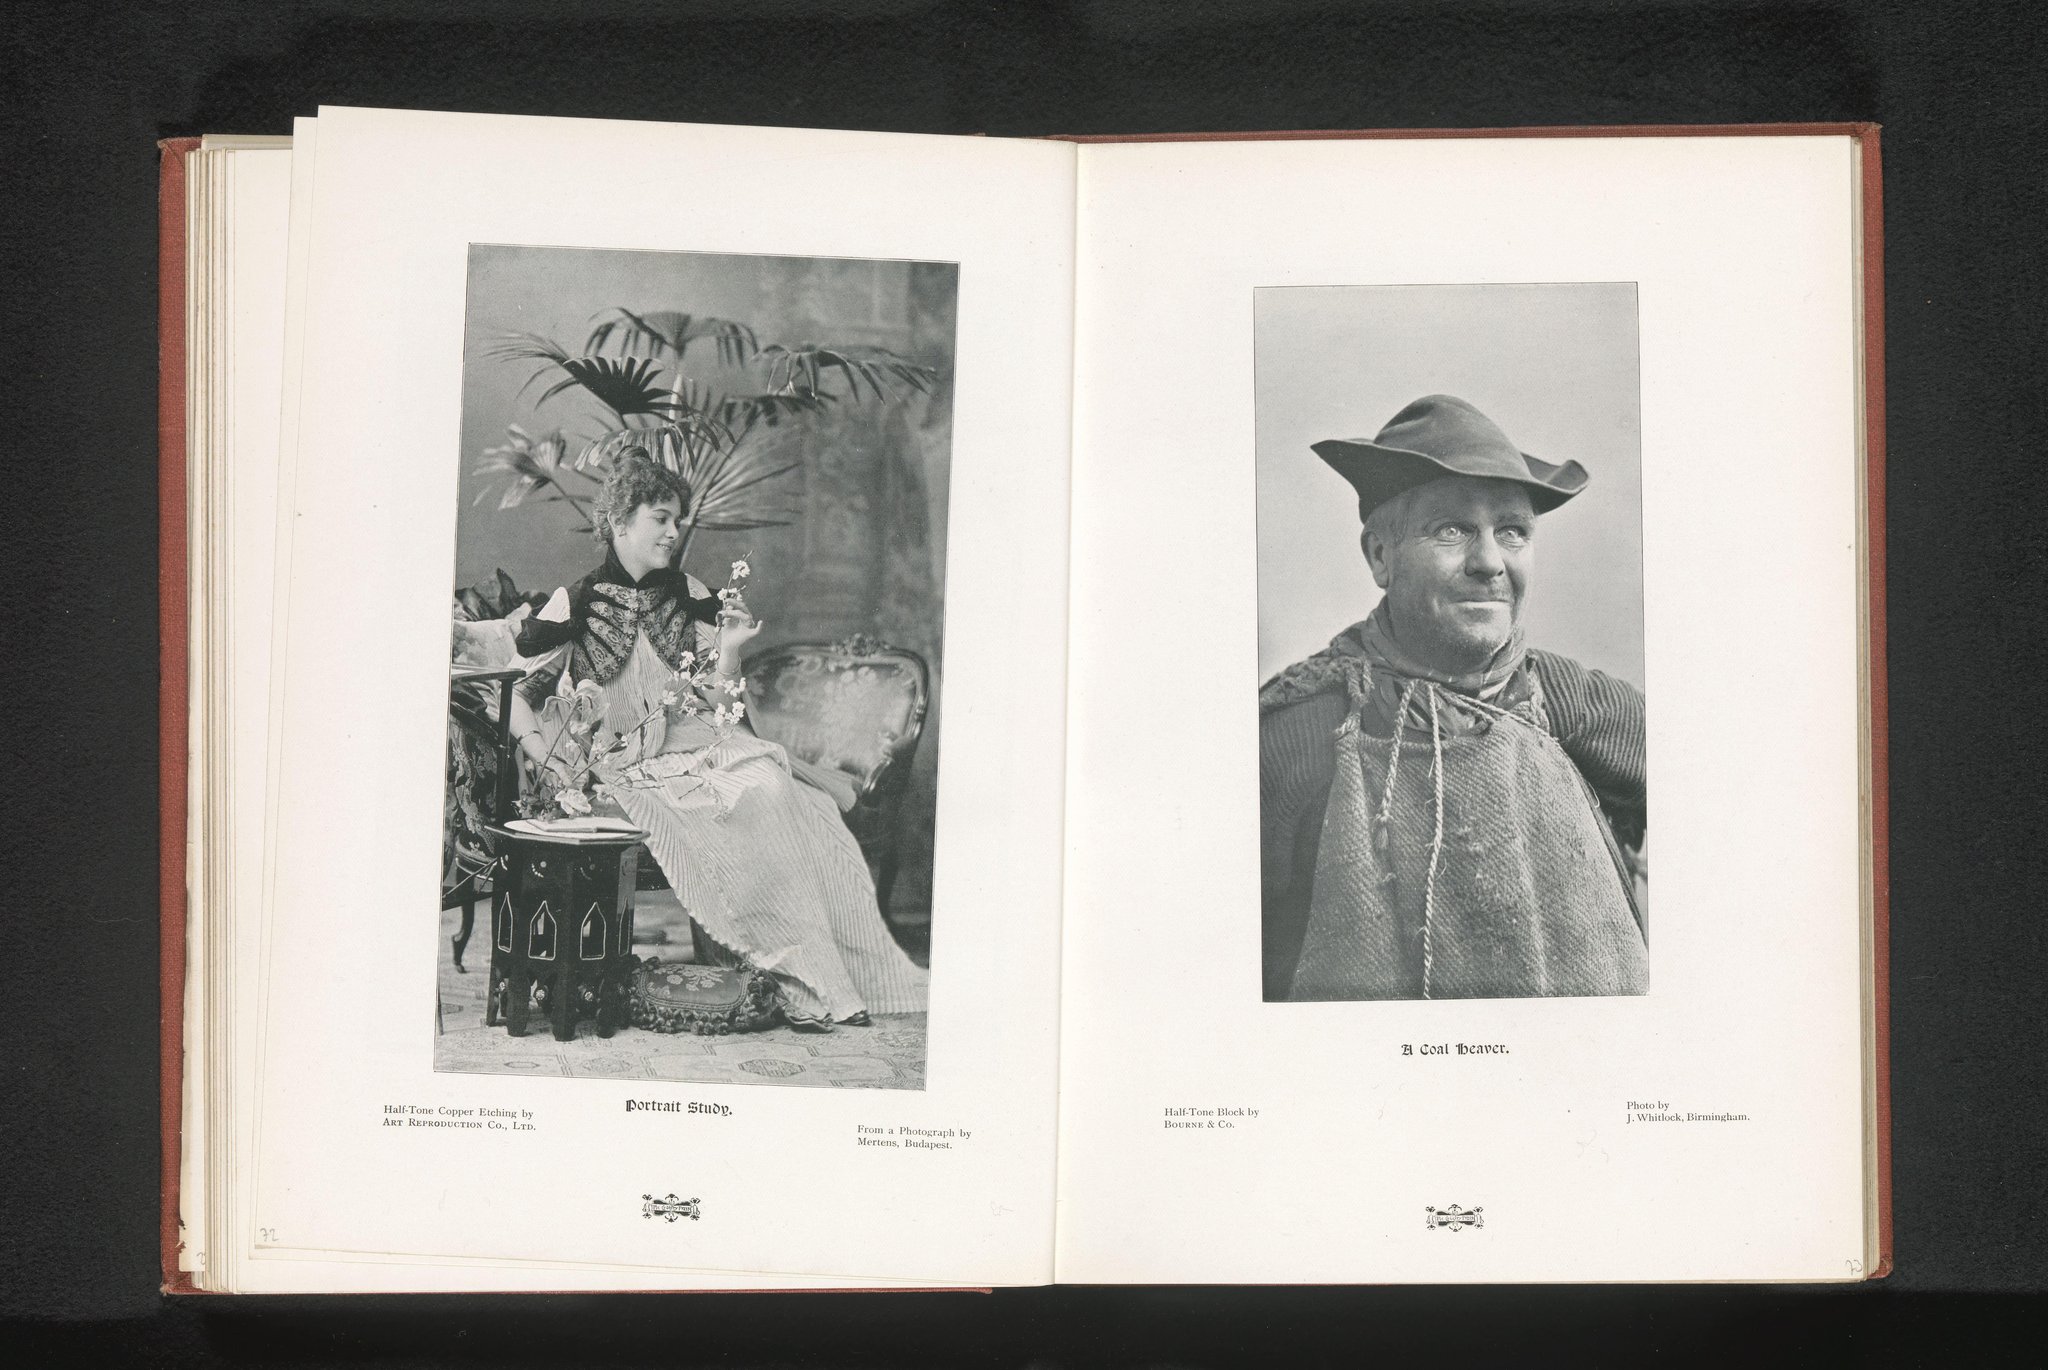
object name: photomechanical print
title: A coal heaver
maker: henry joseph whitlock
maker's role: fotograaf, hofleverancier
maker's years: 1835-1918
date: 1895-1900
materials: paper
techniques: autotype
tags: historical persons - bb - woman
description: Prent op derde ongenummerde pagina na pagina 56.